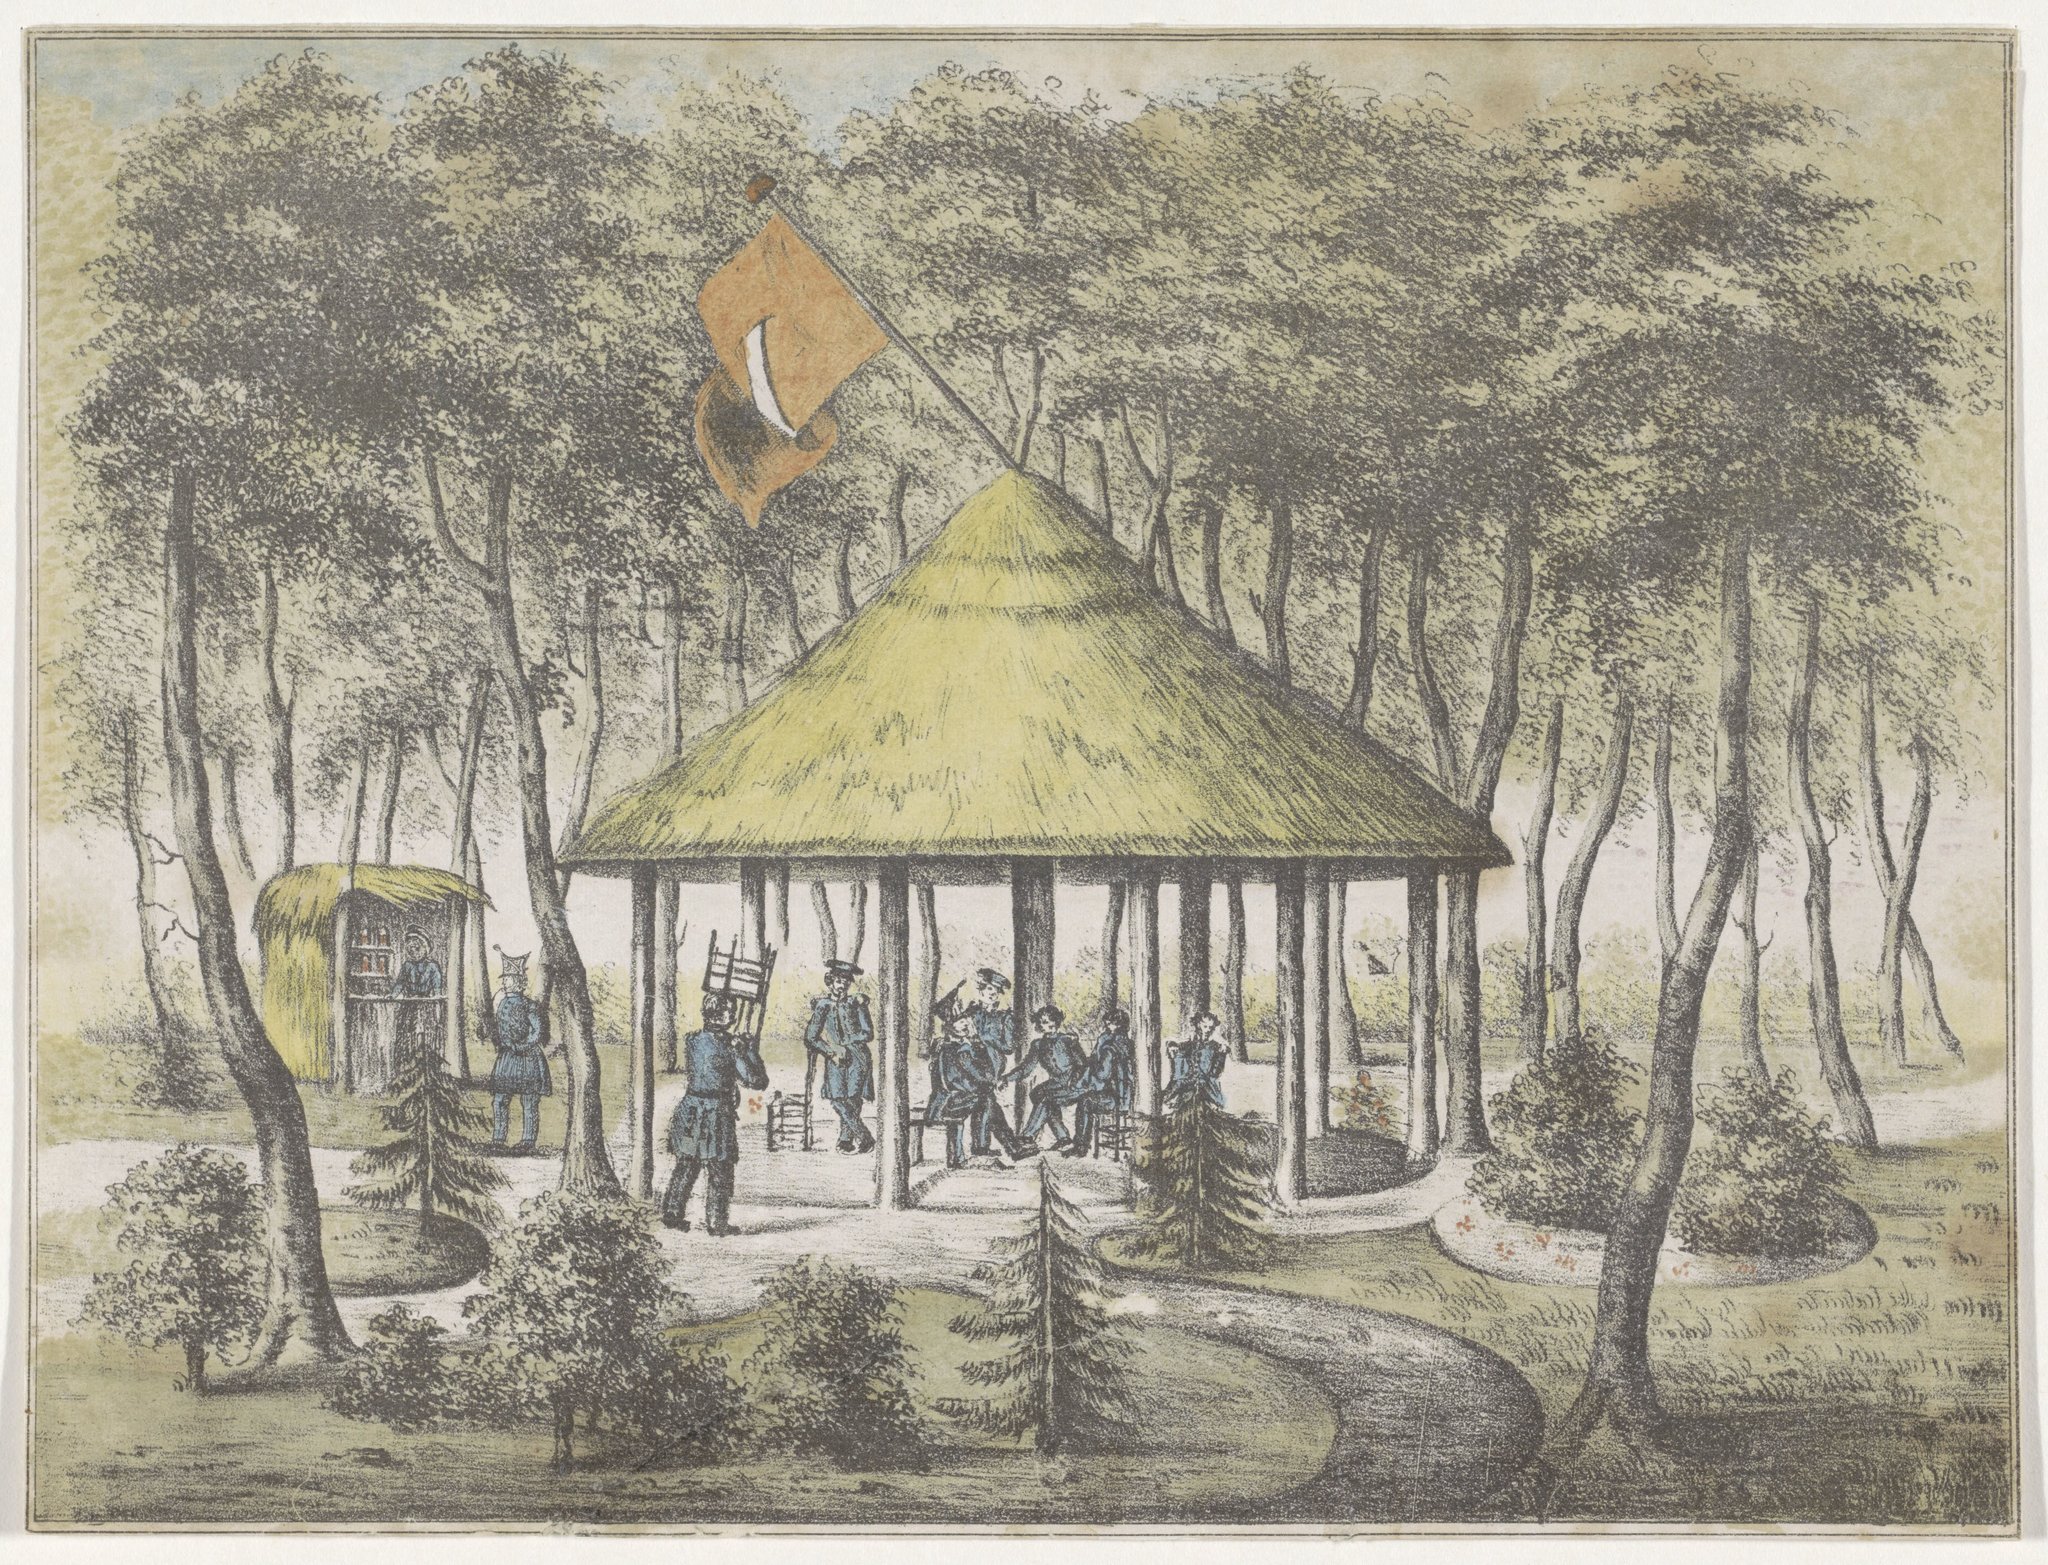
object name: print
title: Gezigt van Tempel en Tuin te Boekel. Opgerigt en aangelegd door de dienstdoende schutterij der Stad Groningen. Uit erkentenis voor het vriendschapplijk onthaal op den 23 Juny 1831, aan de Leden der Sociëteit tot een aandenken aangeboden door J. Oomkens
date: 1831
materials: paper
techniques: hand coloring, lithograph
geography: netherlands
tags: bandstand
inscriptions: collector's mark: Lugt 2228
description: Tempel of muziektent (kiosk) en tuin opgericht door de Vrijwillige schutterij van de Hogeschool van Groningen in Boekel in Noord-Brabant tijdens hun verblijf aldaar als dank voor de vriendelijke onthaal door de dorpsbewoners op 23 juni 1831. Enkele schutters gezeten onder de afdak van de tempel waarop een oranje vlag prijkt. Bij de prent behoort de tekst op een afzonderlijk blad.